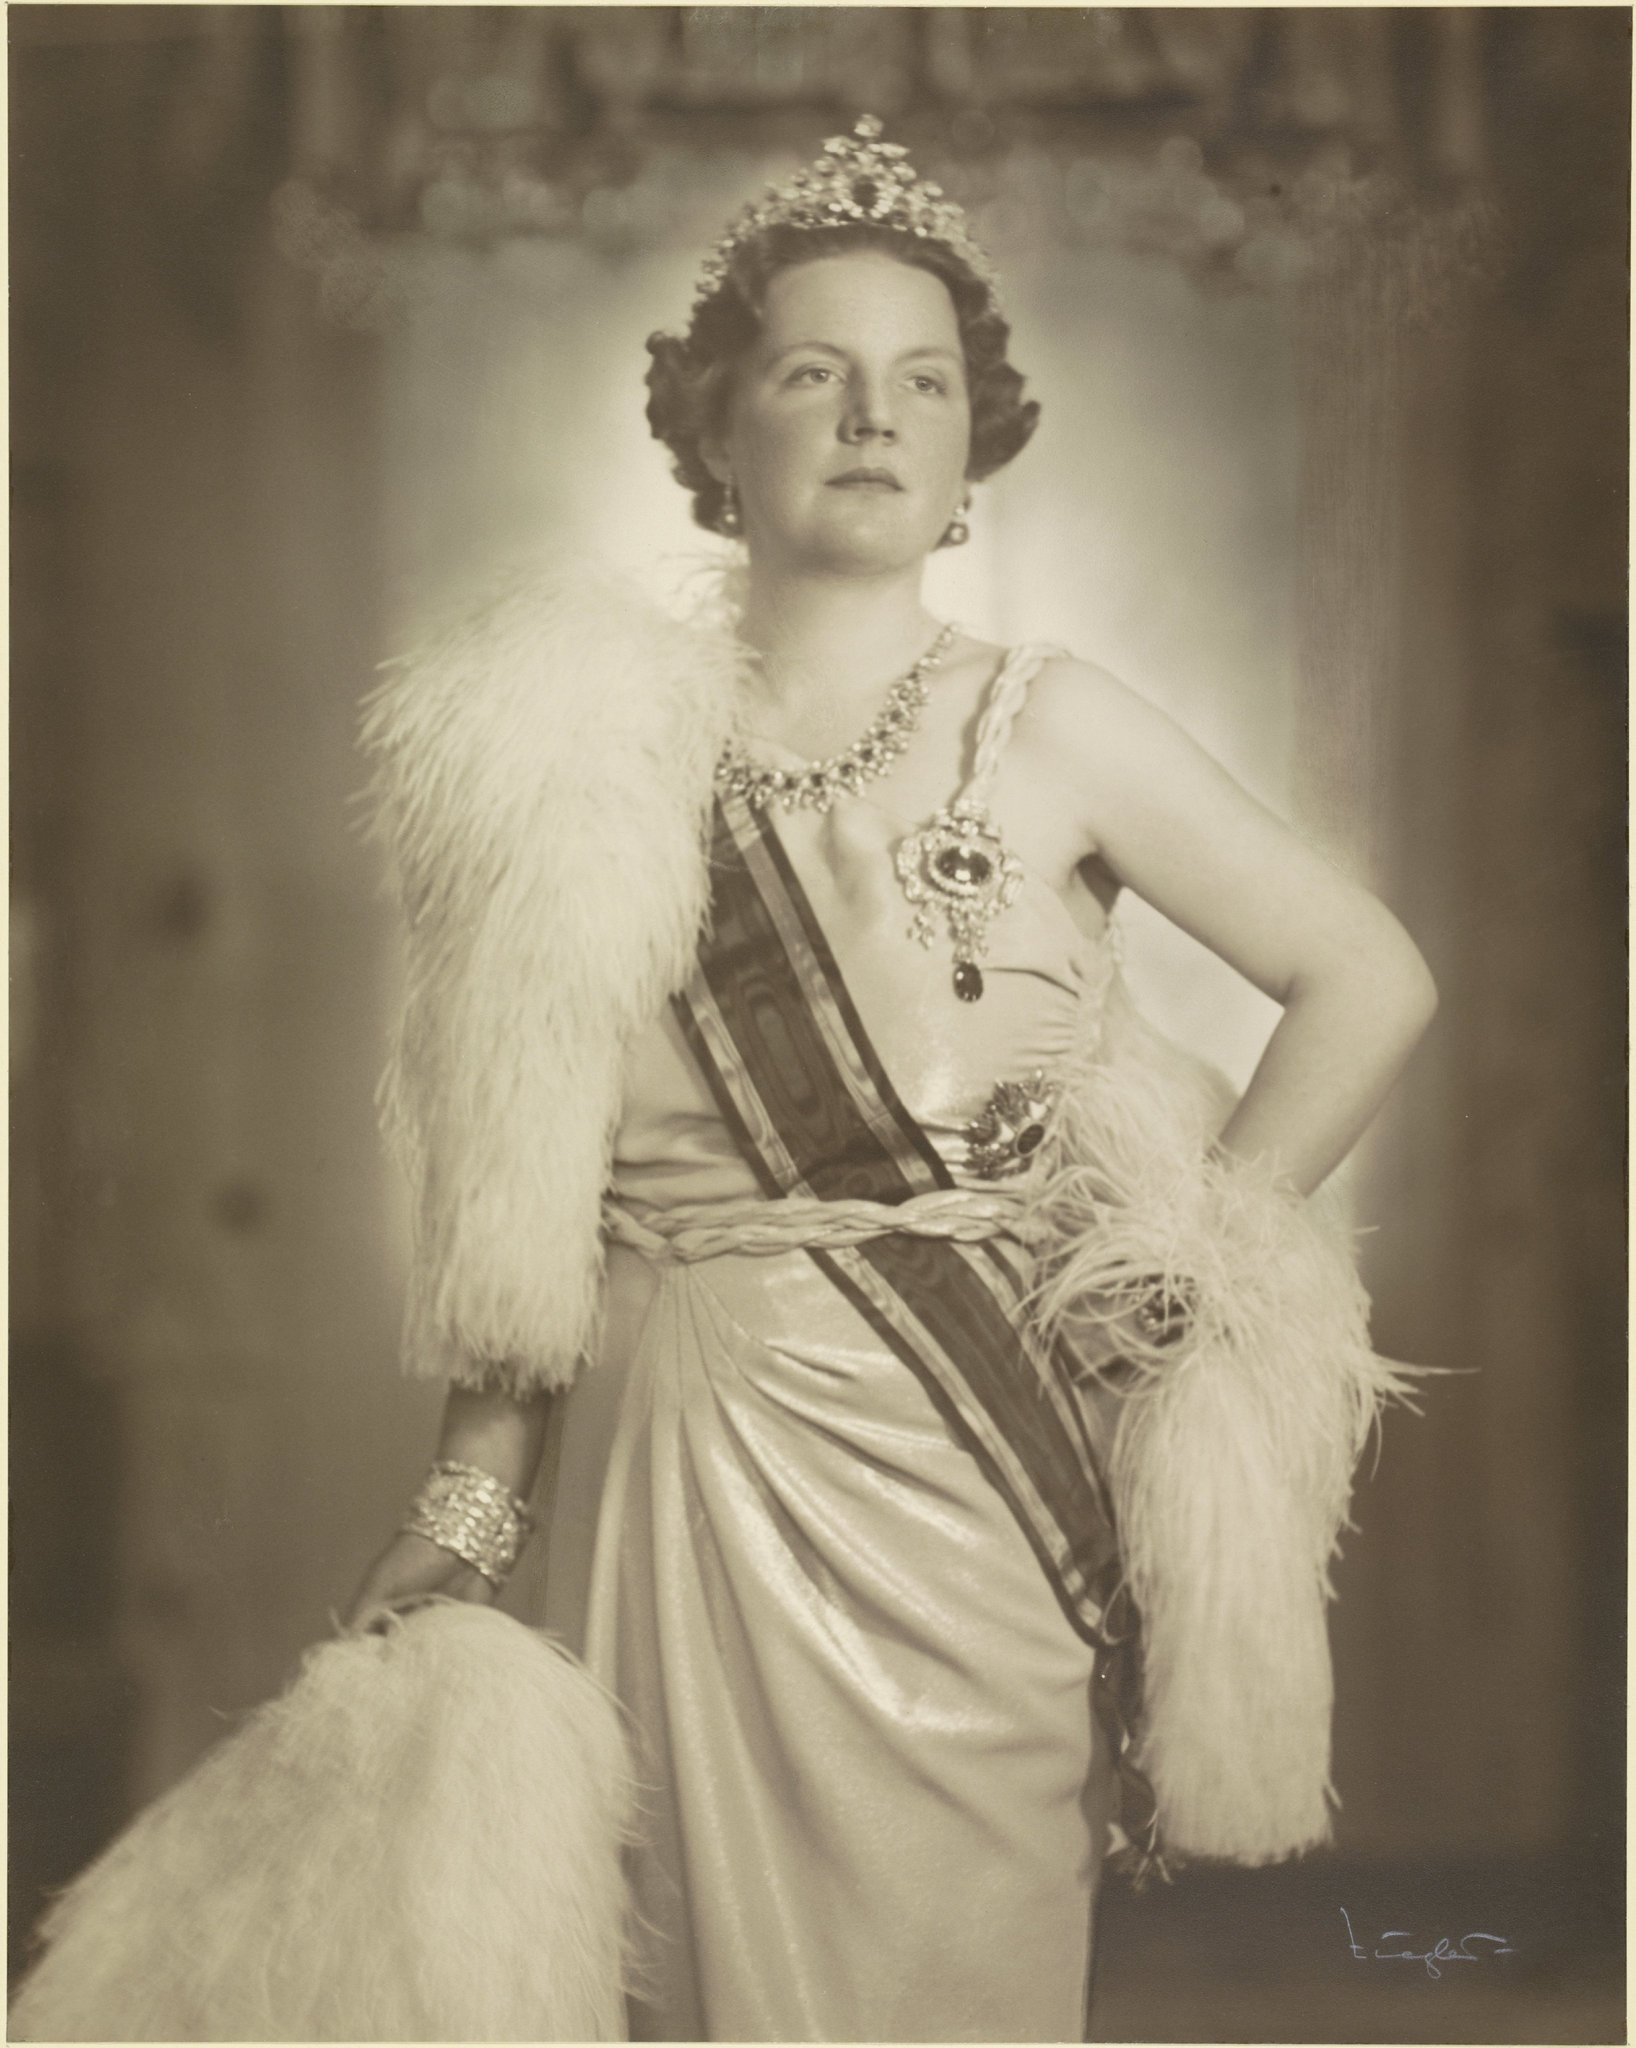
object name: photograph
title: Portret van Juliana, koningin der Nederlanden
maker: franz ziegler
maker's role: fotograaf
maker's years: 1893-1939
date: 1908-1937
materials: photographic support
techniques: photography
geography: the hague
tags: the hague, juliana of the netherlands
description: De hier vermelde titel verwijst naar de hoogst verkregen titel van de geportretteerde, niet per se naar de titel die de geportretteerde op deze voorstelling draagt.